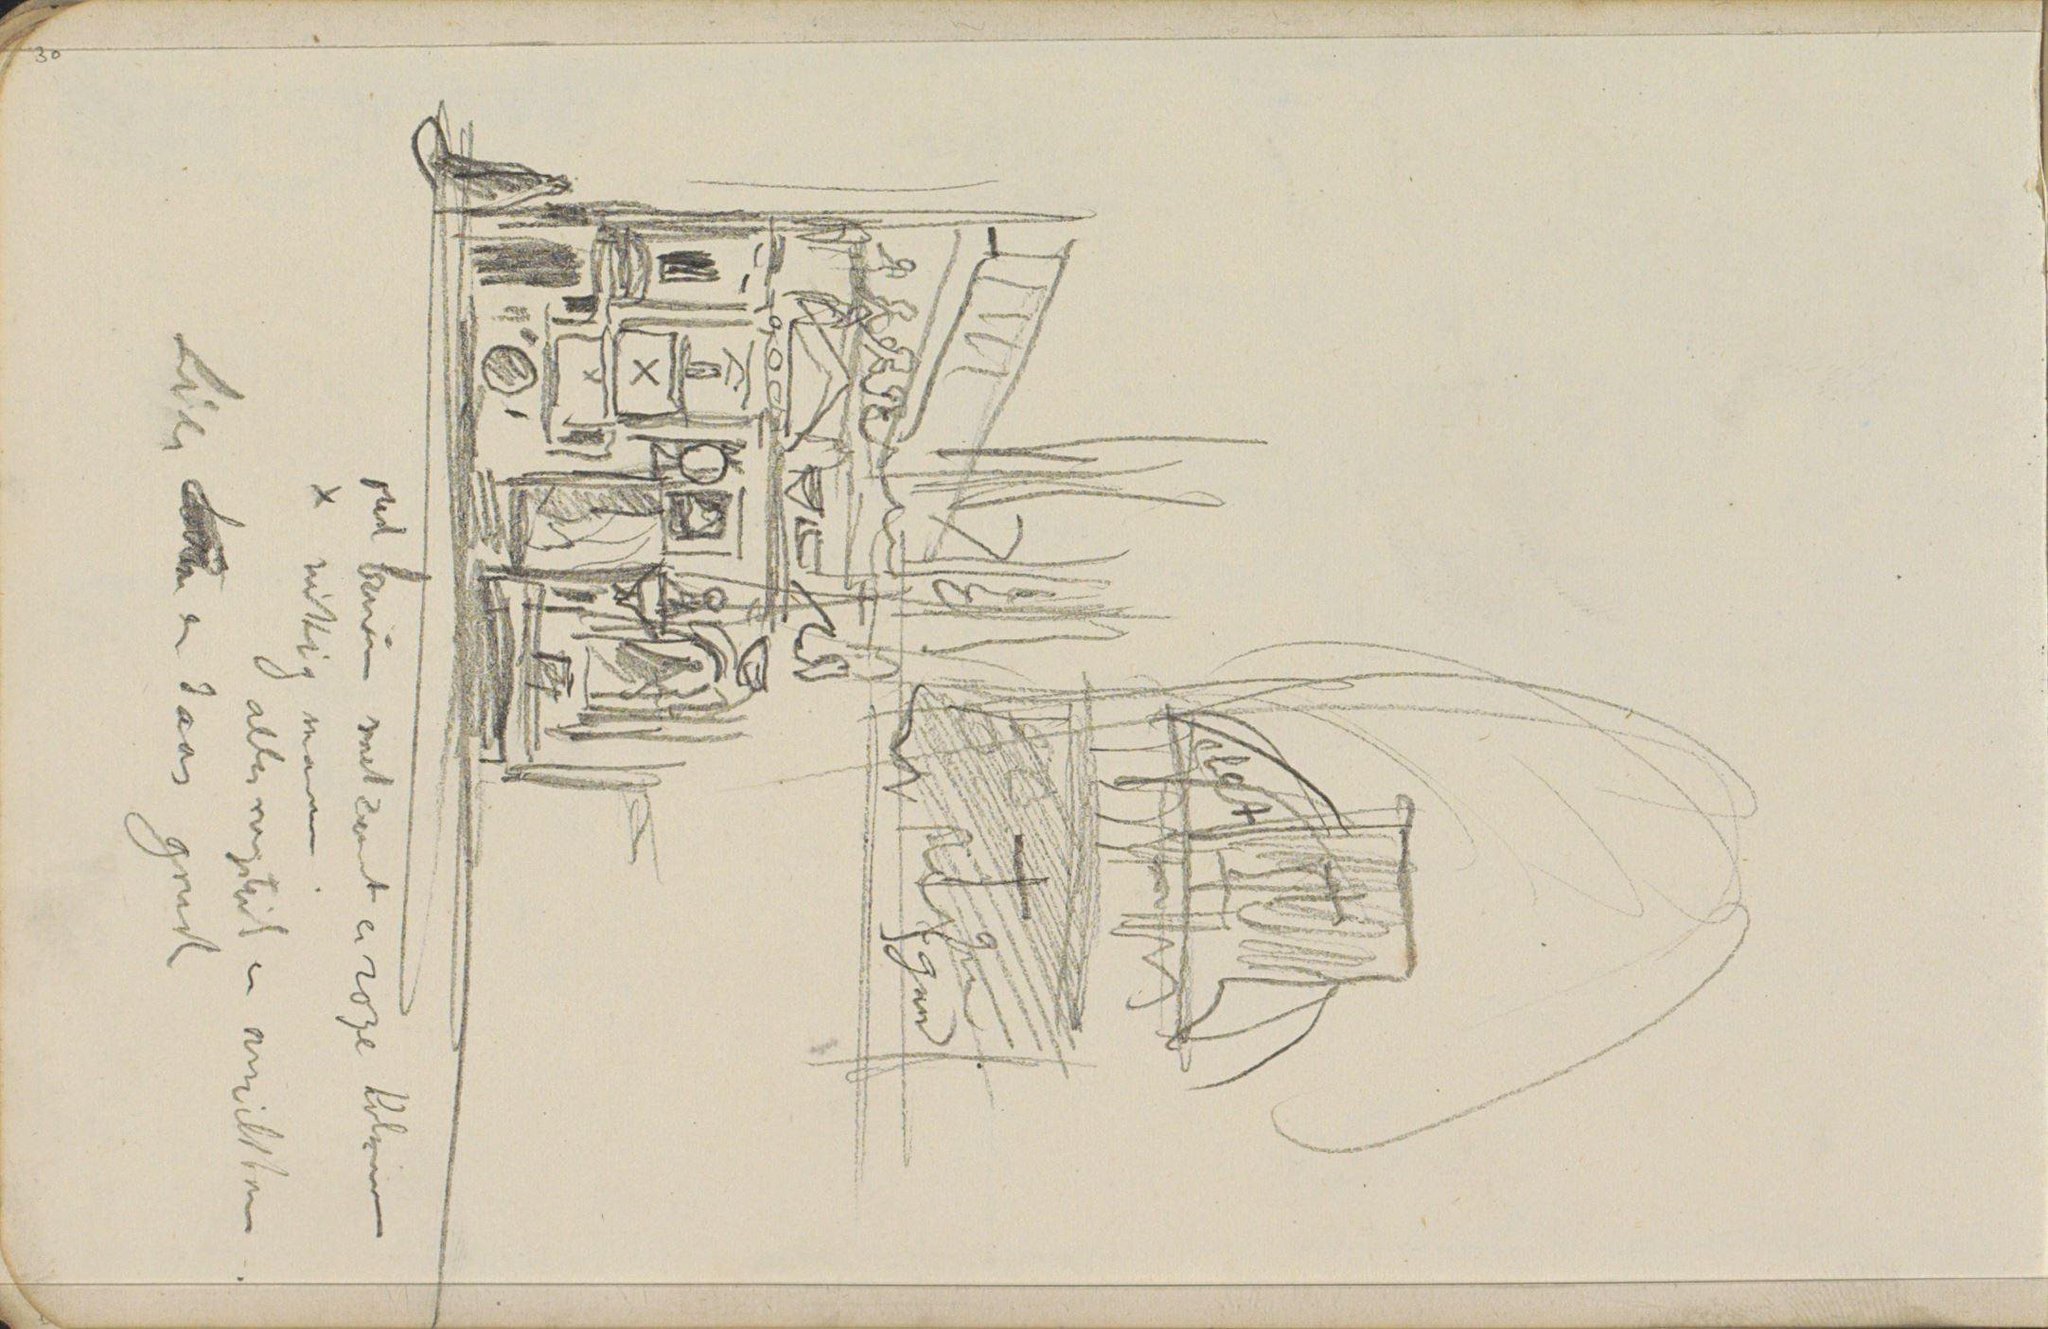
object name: sketchbook leaf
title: Architectuurstudies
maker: marius bauer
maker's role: draughtsman, print maker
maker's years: 1867-1932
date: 1902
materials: paper, pencil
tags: architecture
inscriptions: kleurnotitie, handgeschreven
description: Pagina 30 uit een schetsboek met 30 bladen.